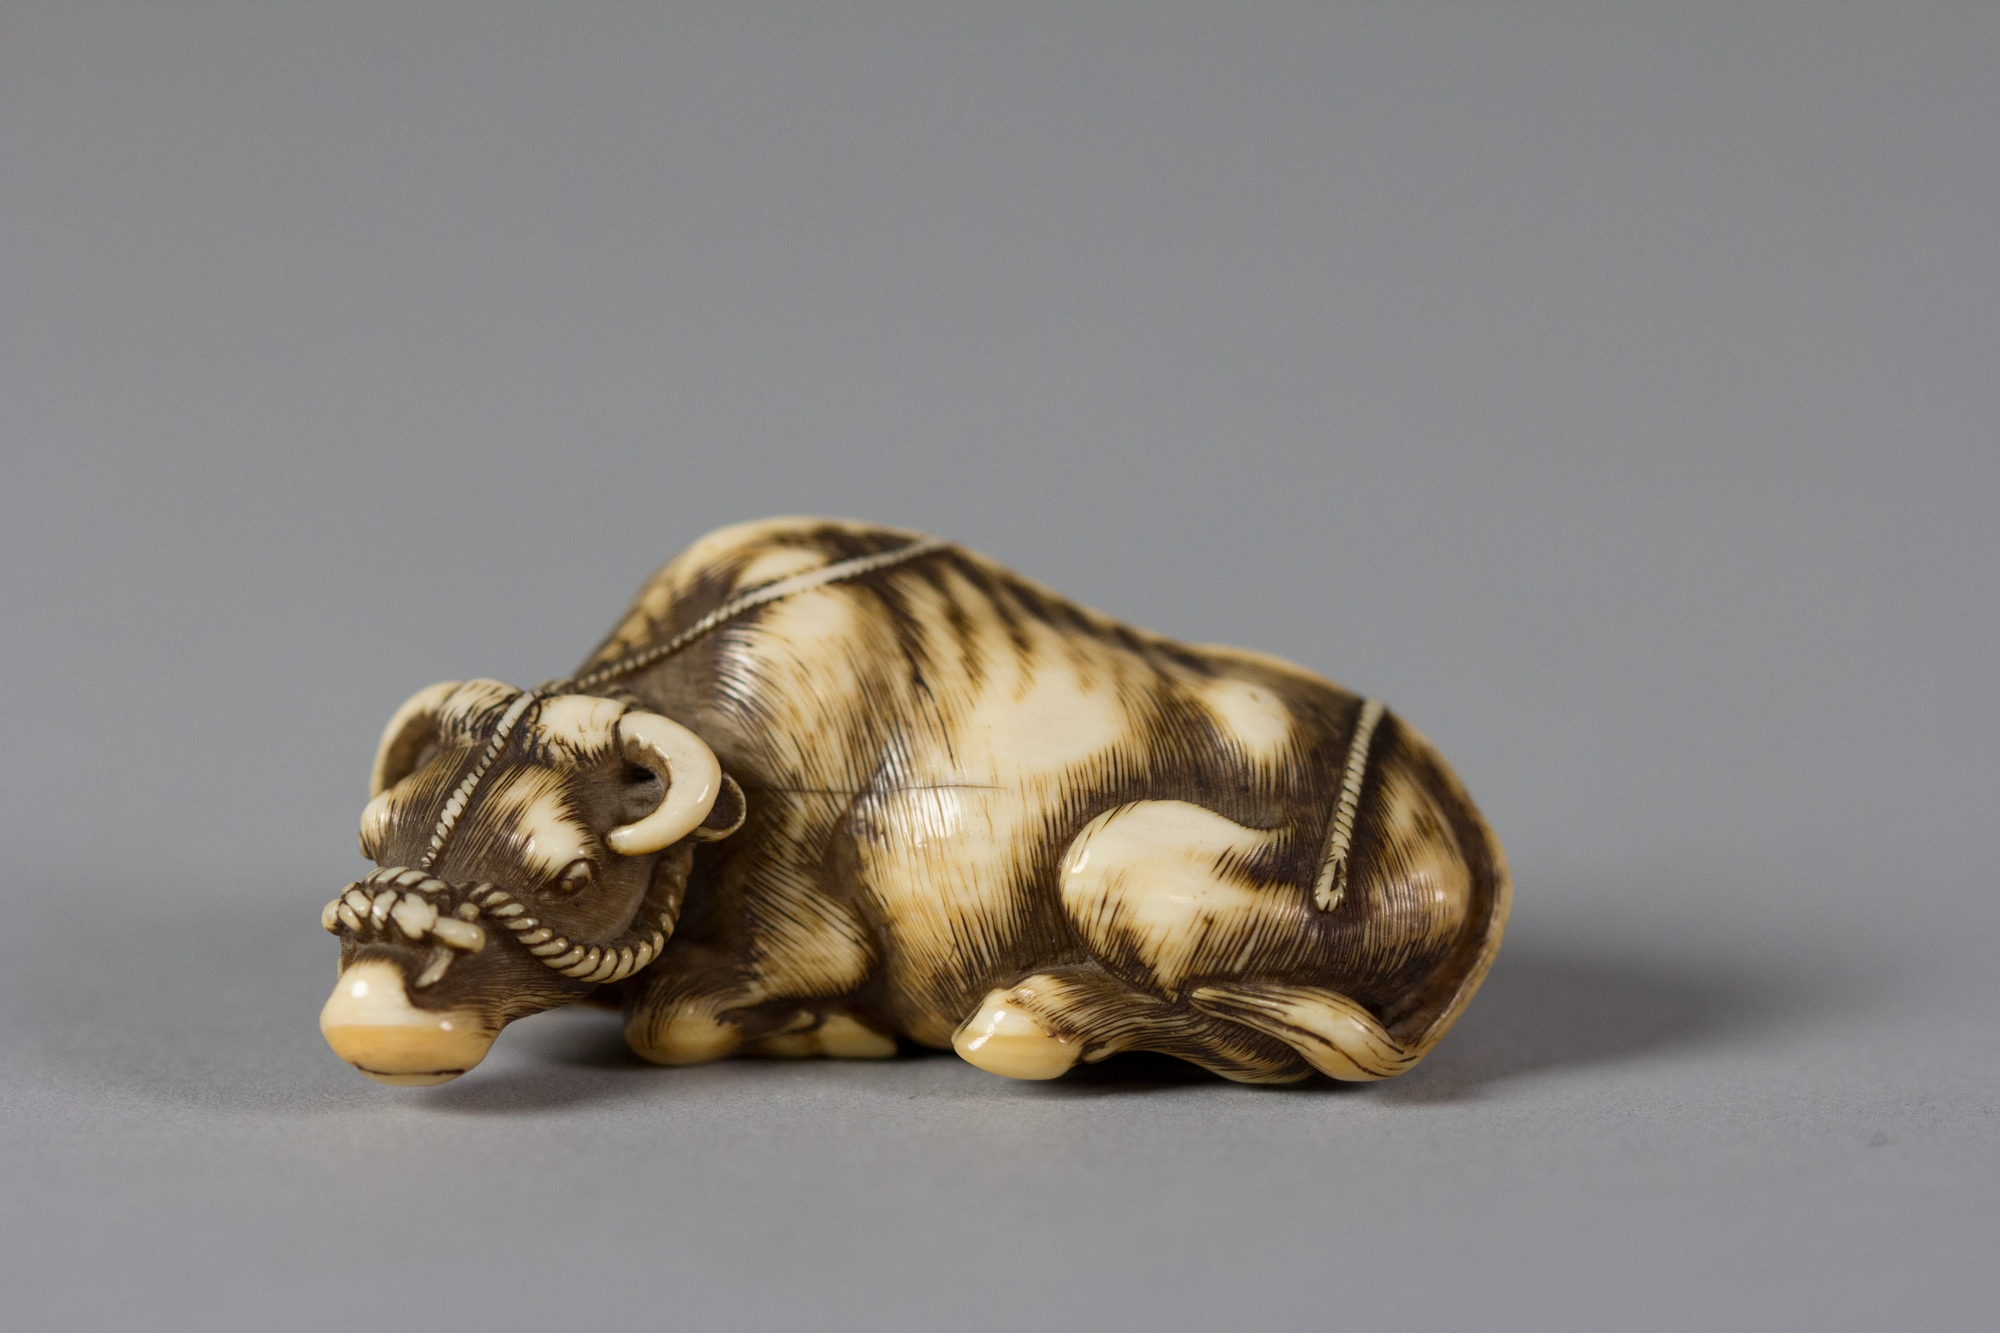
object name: netsuke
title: Ox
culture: japanese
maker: tomotada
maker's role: artist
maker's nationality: japanese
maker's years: 1777-1833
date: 1767-1833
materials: ivory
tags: animals